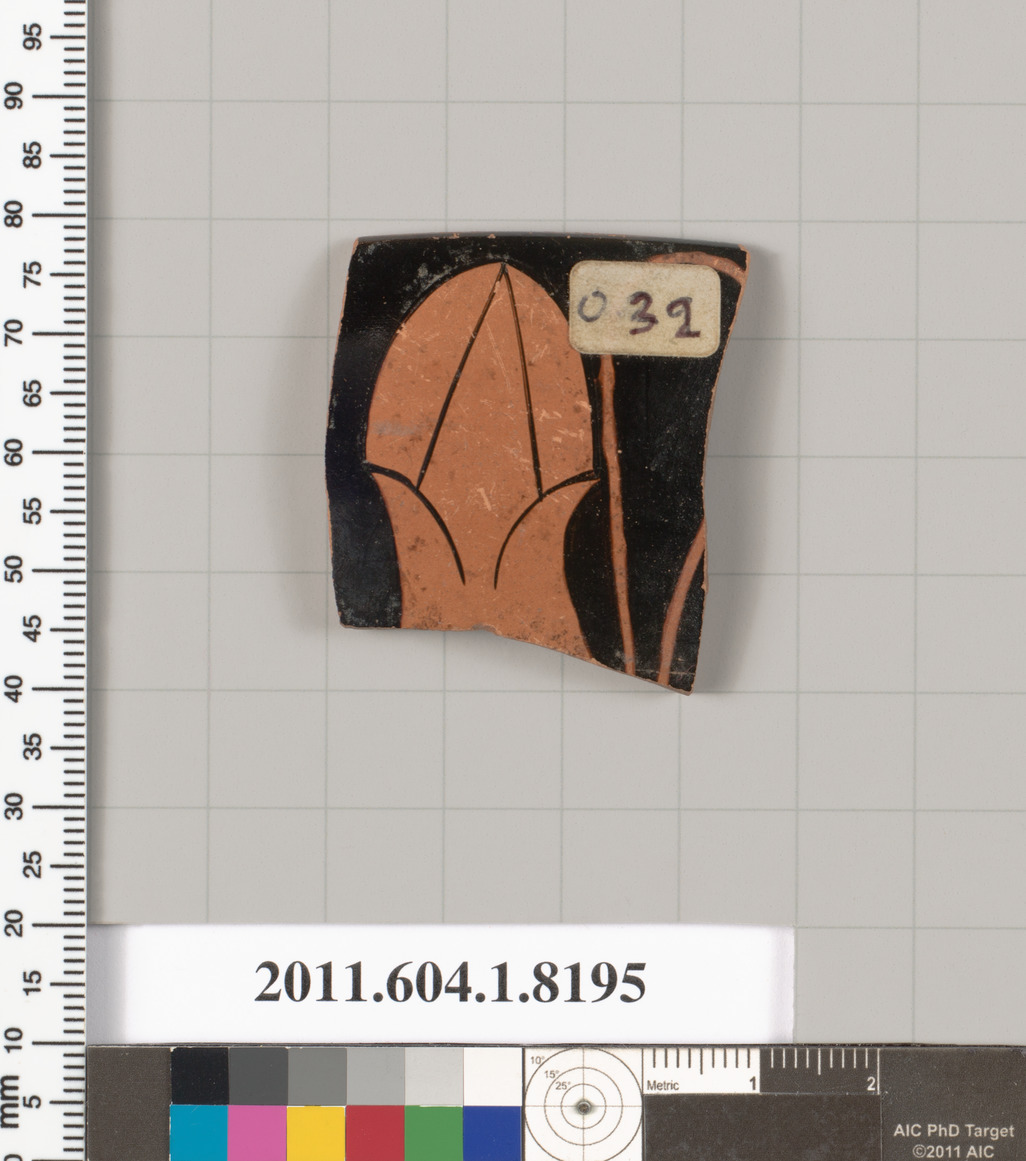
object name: kylix fragment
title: Terracotta rim fragment of a kylix (drinking cup)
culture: greek, attic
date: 520-510 BCE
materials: terracotta